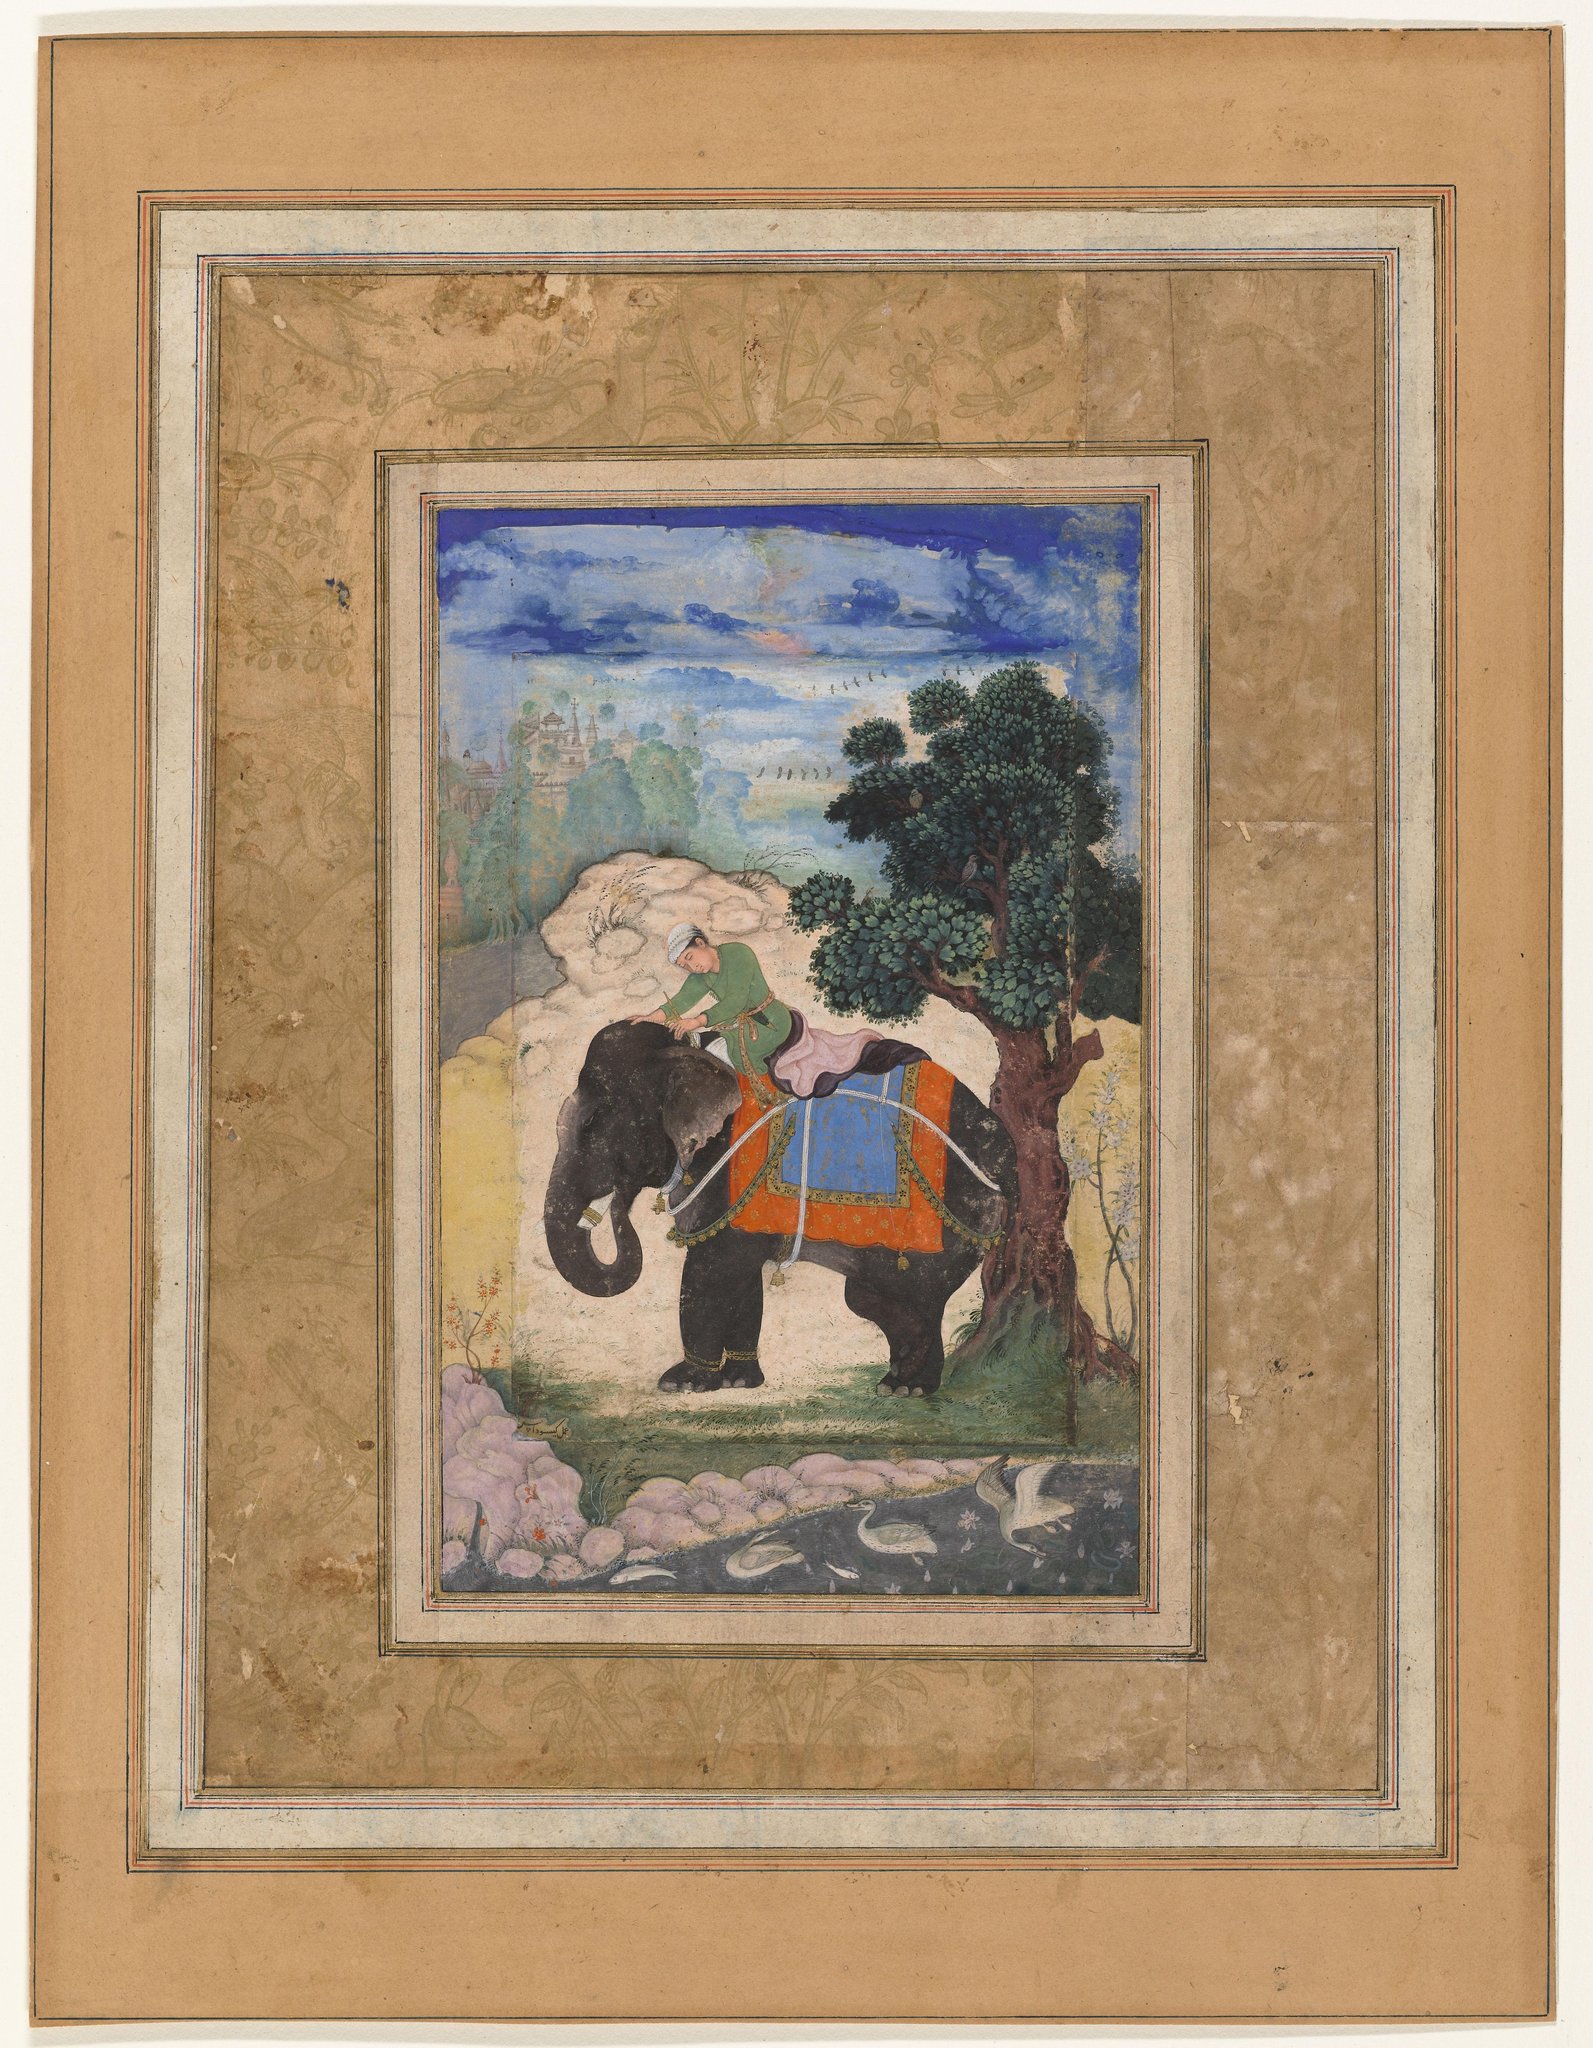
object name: drawing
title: Elephant and rider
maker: keshavdas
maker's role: draughtsman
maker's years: 1555-1617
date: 1580-1590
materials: paint, gouache, paper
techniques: brush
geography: india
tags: trunked animals: elephant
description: The elephant and rider rest in the shade of a tree. The animal’s legs are chained together to prevent sudden movements. The miniaturist Kesu Das was active in the workshop of the Mughal emperor Akbar. He was a master in the rendering of light on fabric.